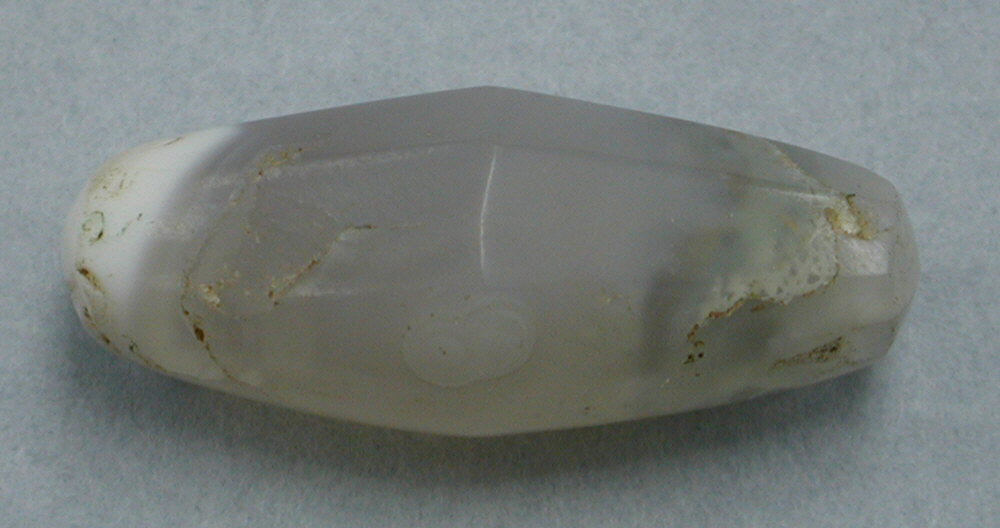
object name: ritual stone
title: Polishing Stone (pulidor)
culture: mexican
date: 1501-1600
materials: stone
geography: mexico